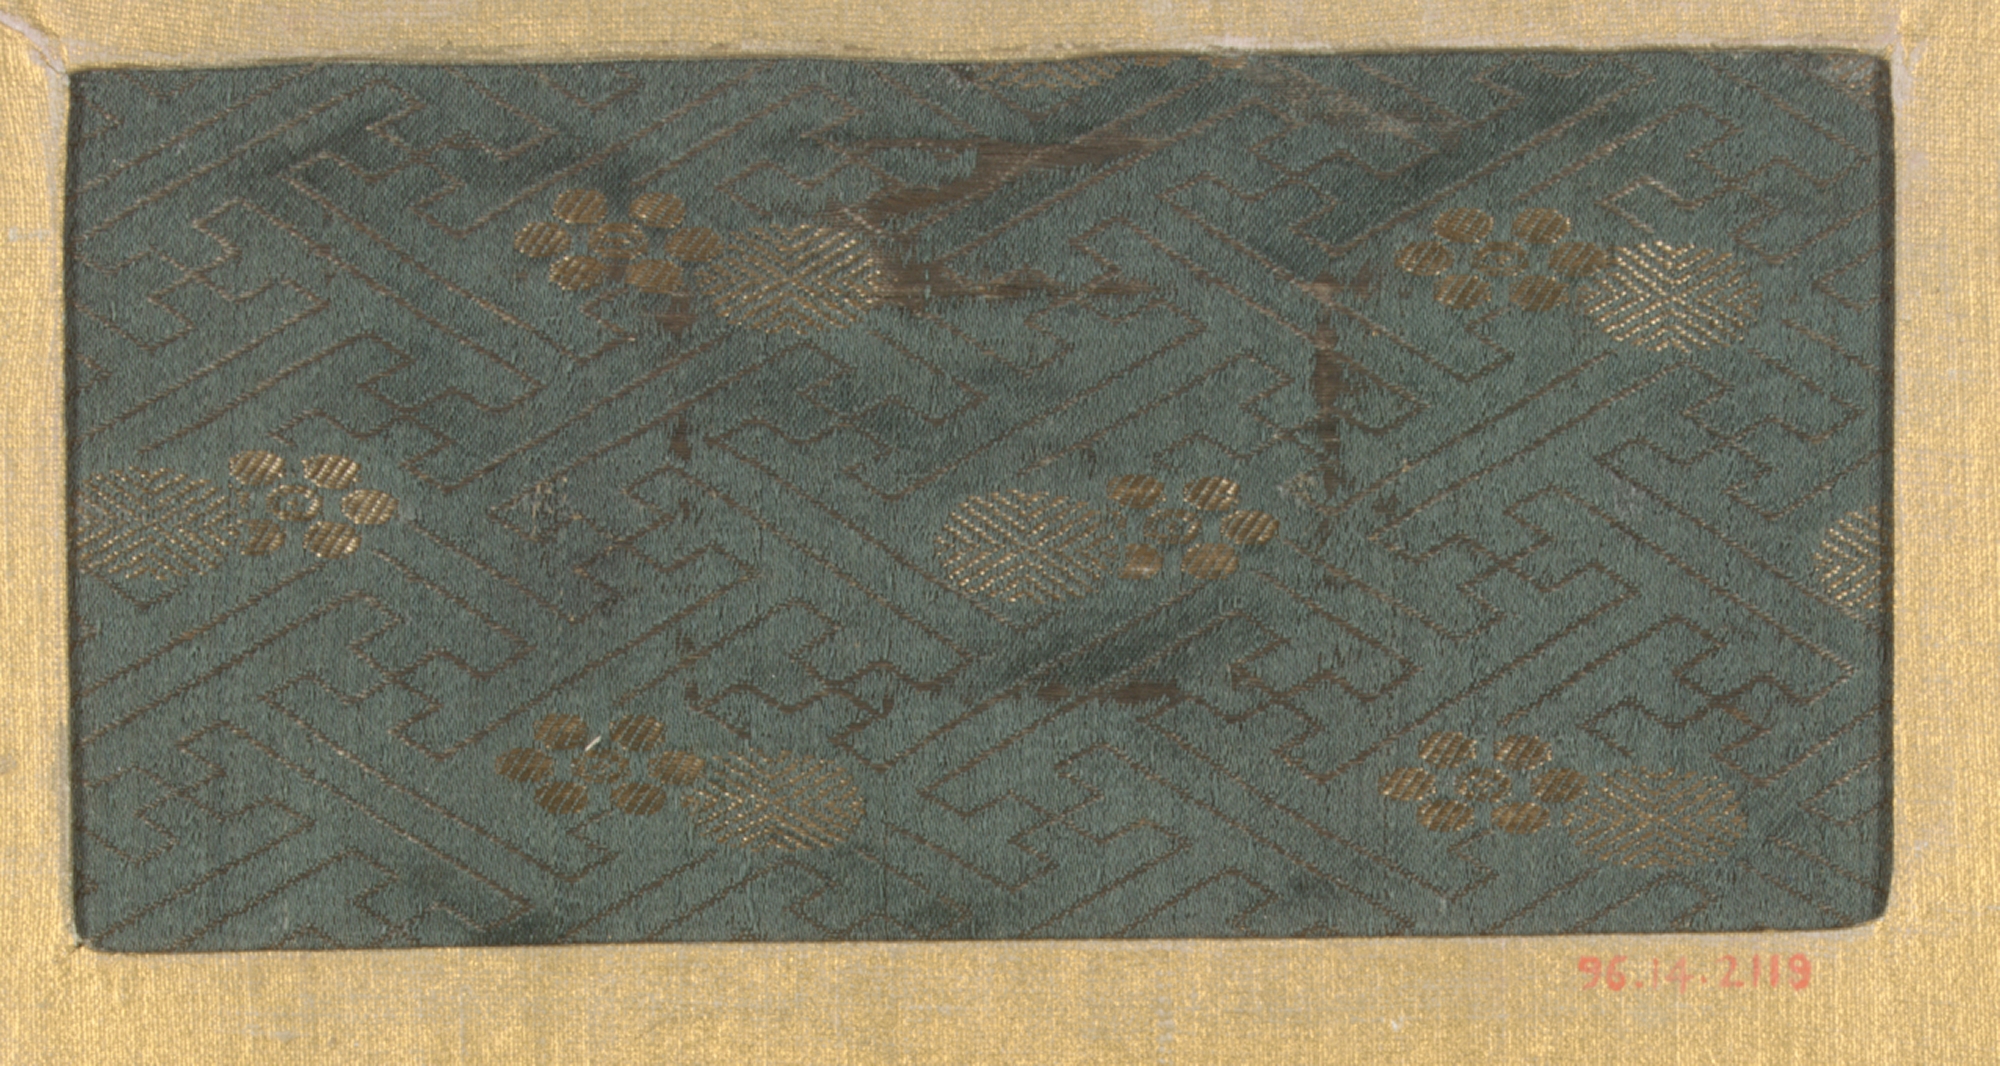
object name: piece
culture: japanese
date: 1701-1900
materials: silk